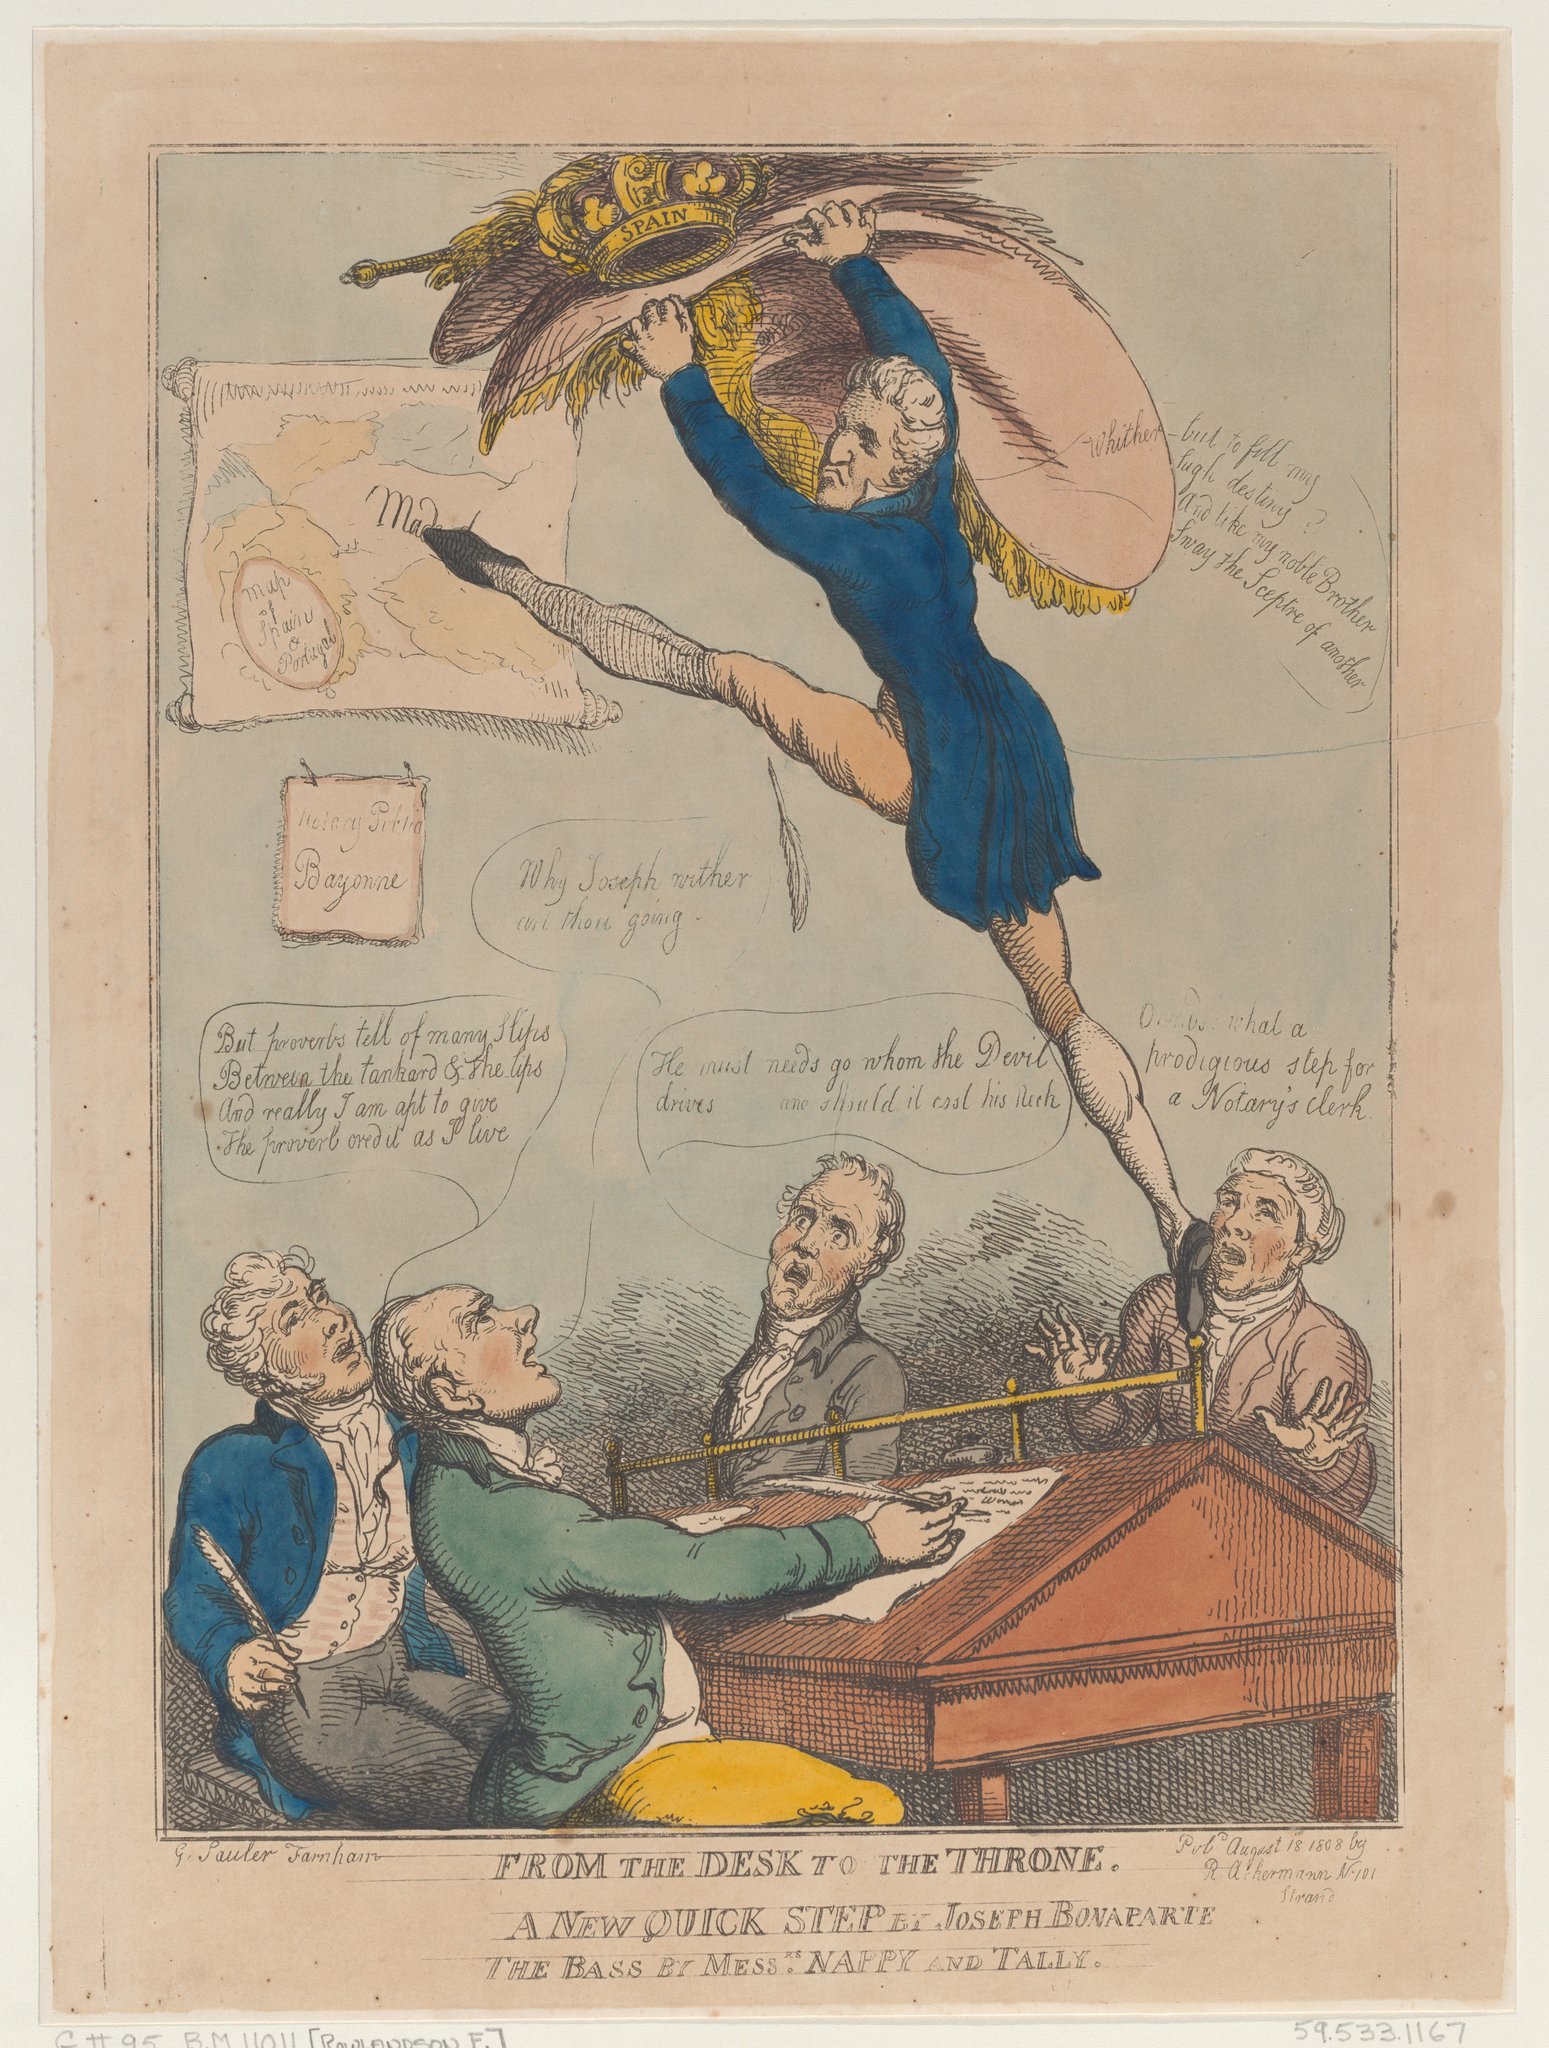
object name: print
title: From the Desk to the Throne, A New Quick Step by Joseph Bonaparte the Bass By Messers Nappy and Tally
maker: thomas rowlandson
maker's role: artist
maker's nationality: british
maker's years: 1757-1827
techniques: etching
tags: satire,men,politics